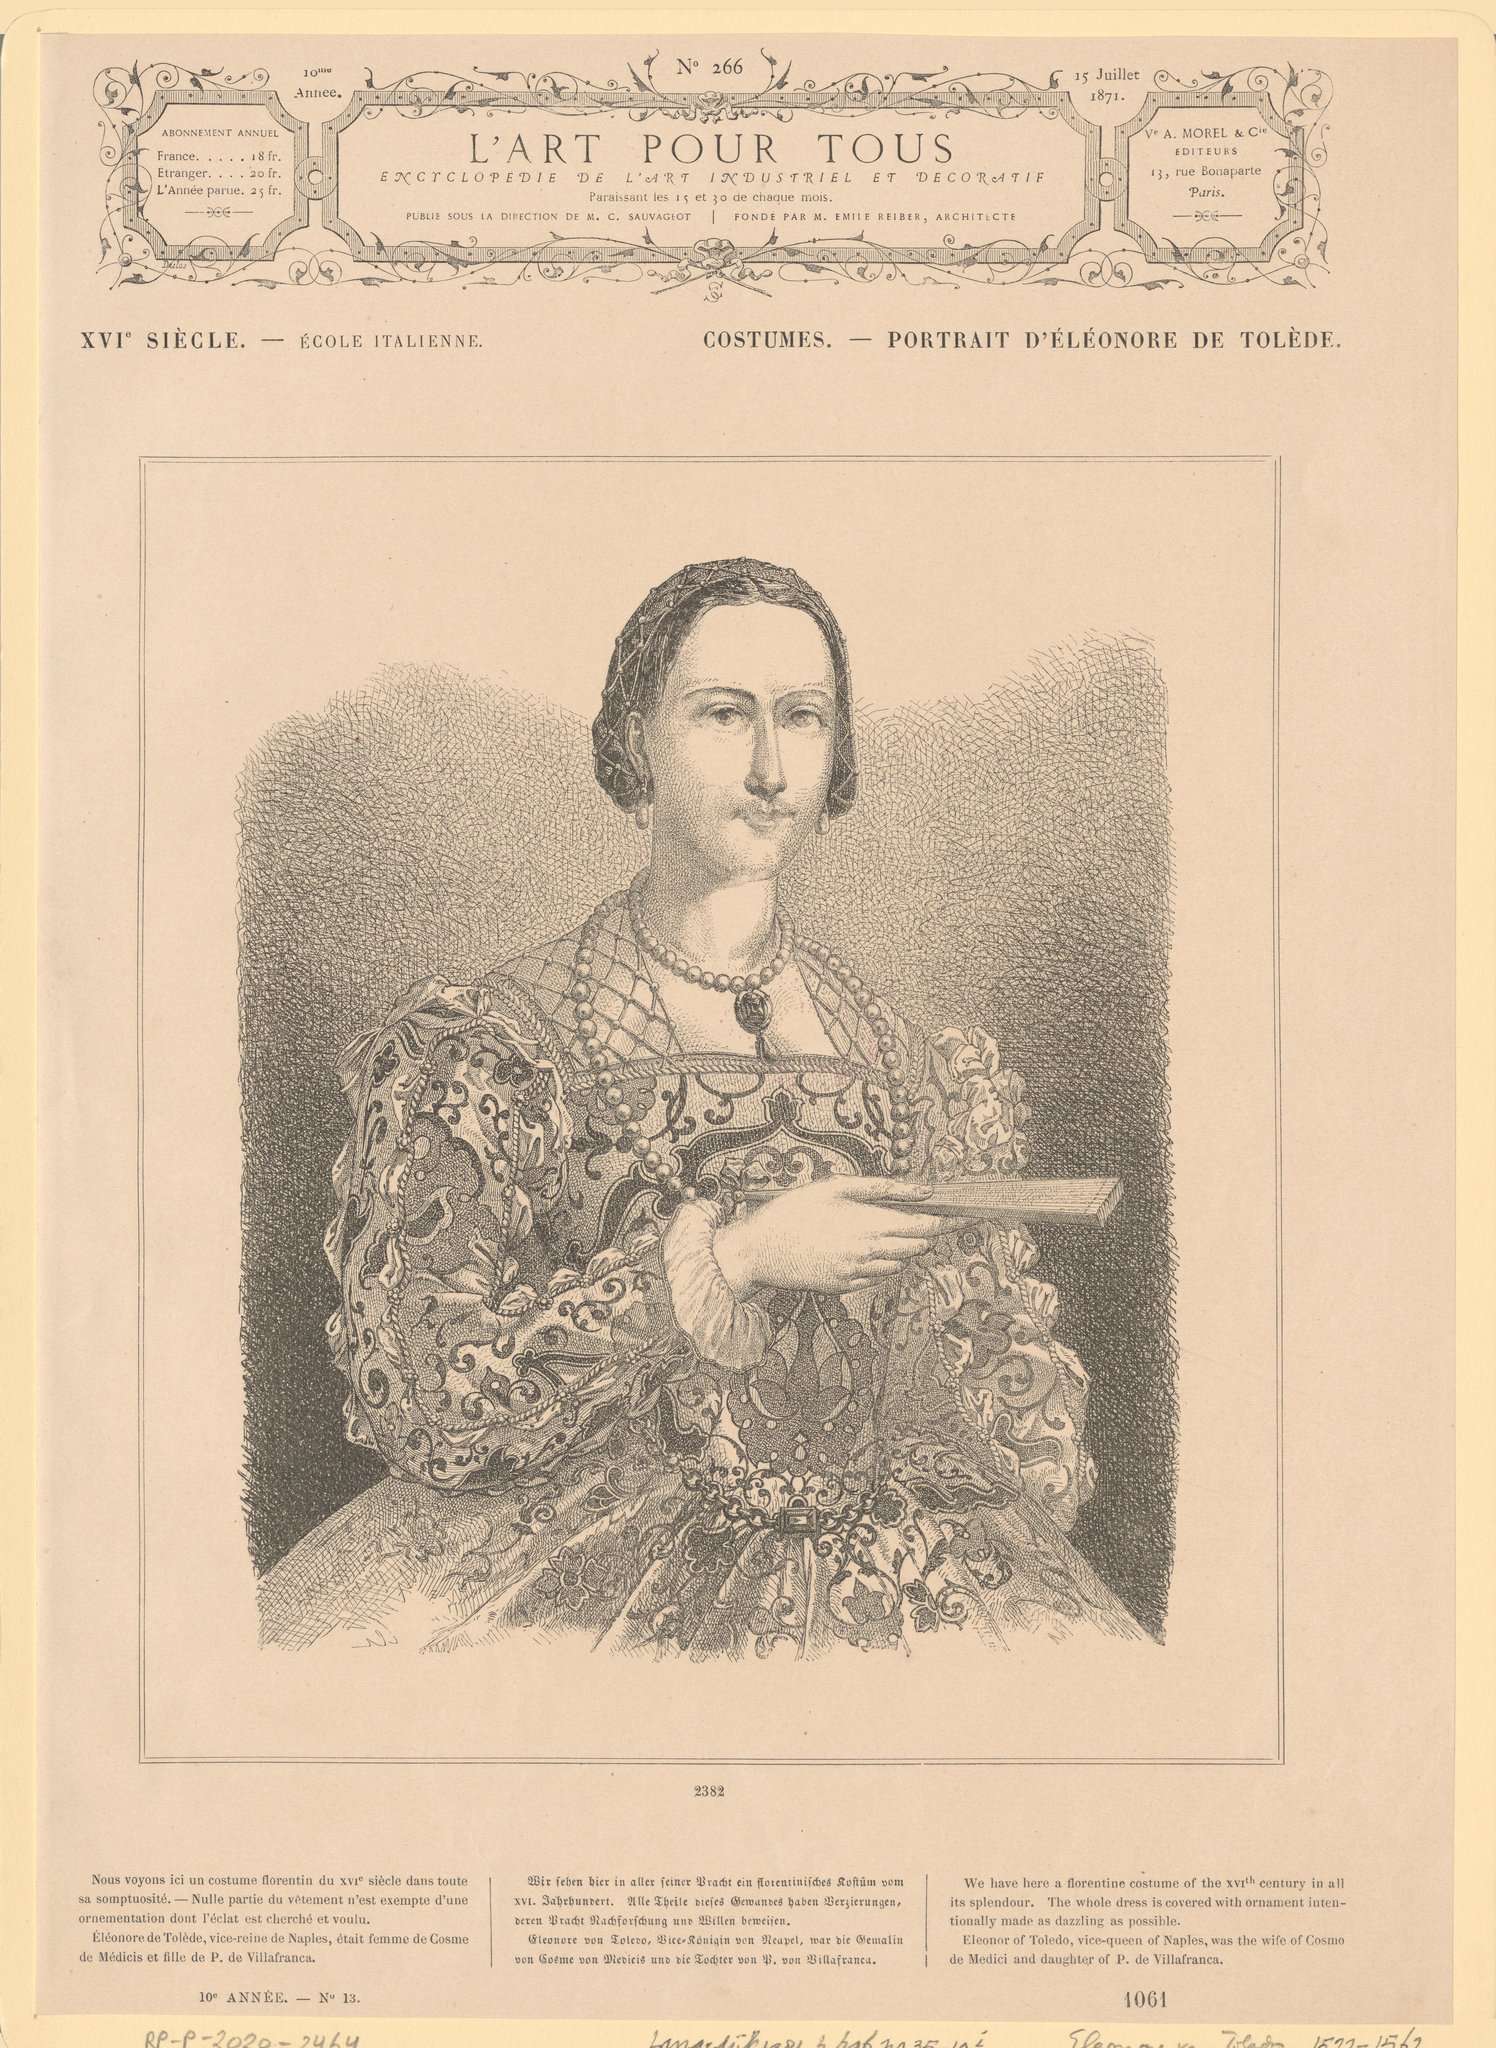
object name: titelblad, titelpagina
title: Titelpagina voor: L'Art pour tous (...), 1871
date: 1871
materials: paper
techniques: letterpress printing, line block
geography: paris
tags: historical persons - bb - woman, fan, pearl; pearl necklace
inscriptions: collector's mark: Lugt 3937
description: Titelpagina voor: L'Art pour tous: encyclopedie de l'art industriel et décoratif 10 (1871), nr. 266, 15 juli 1871.